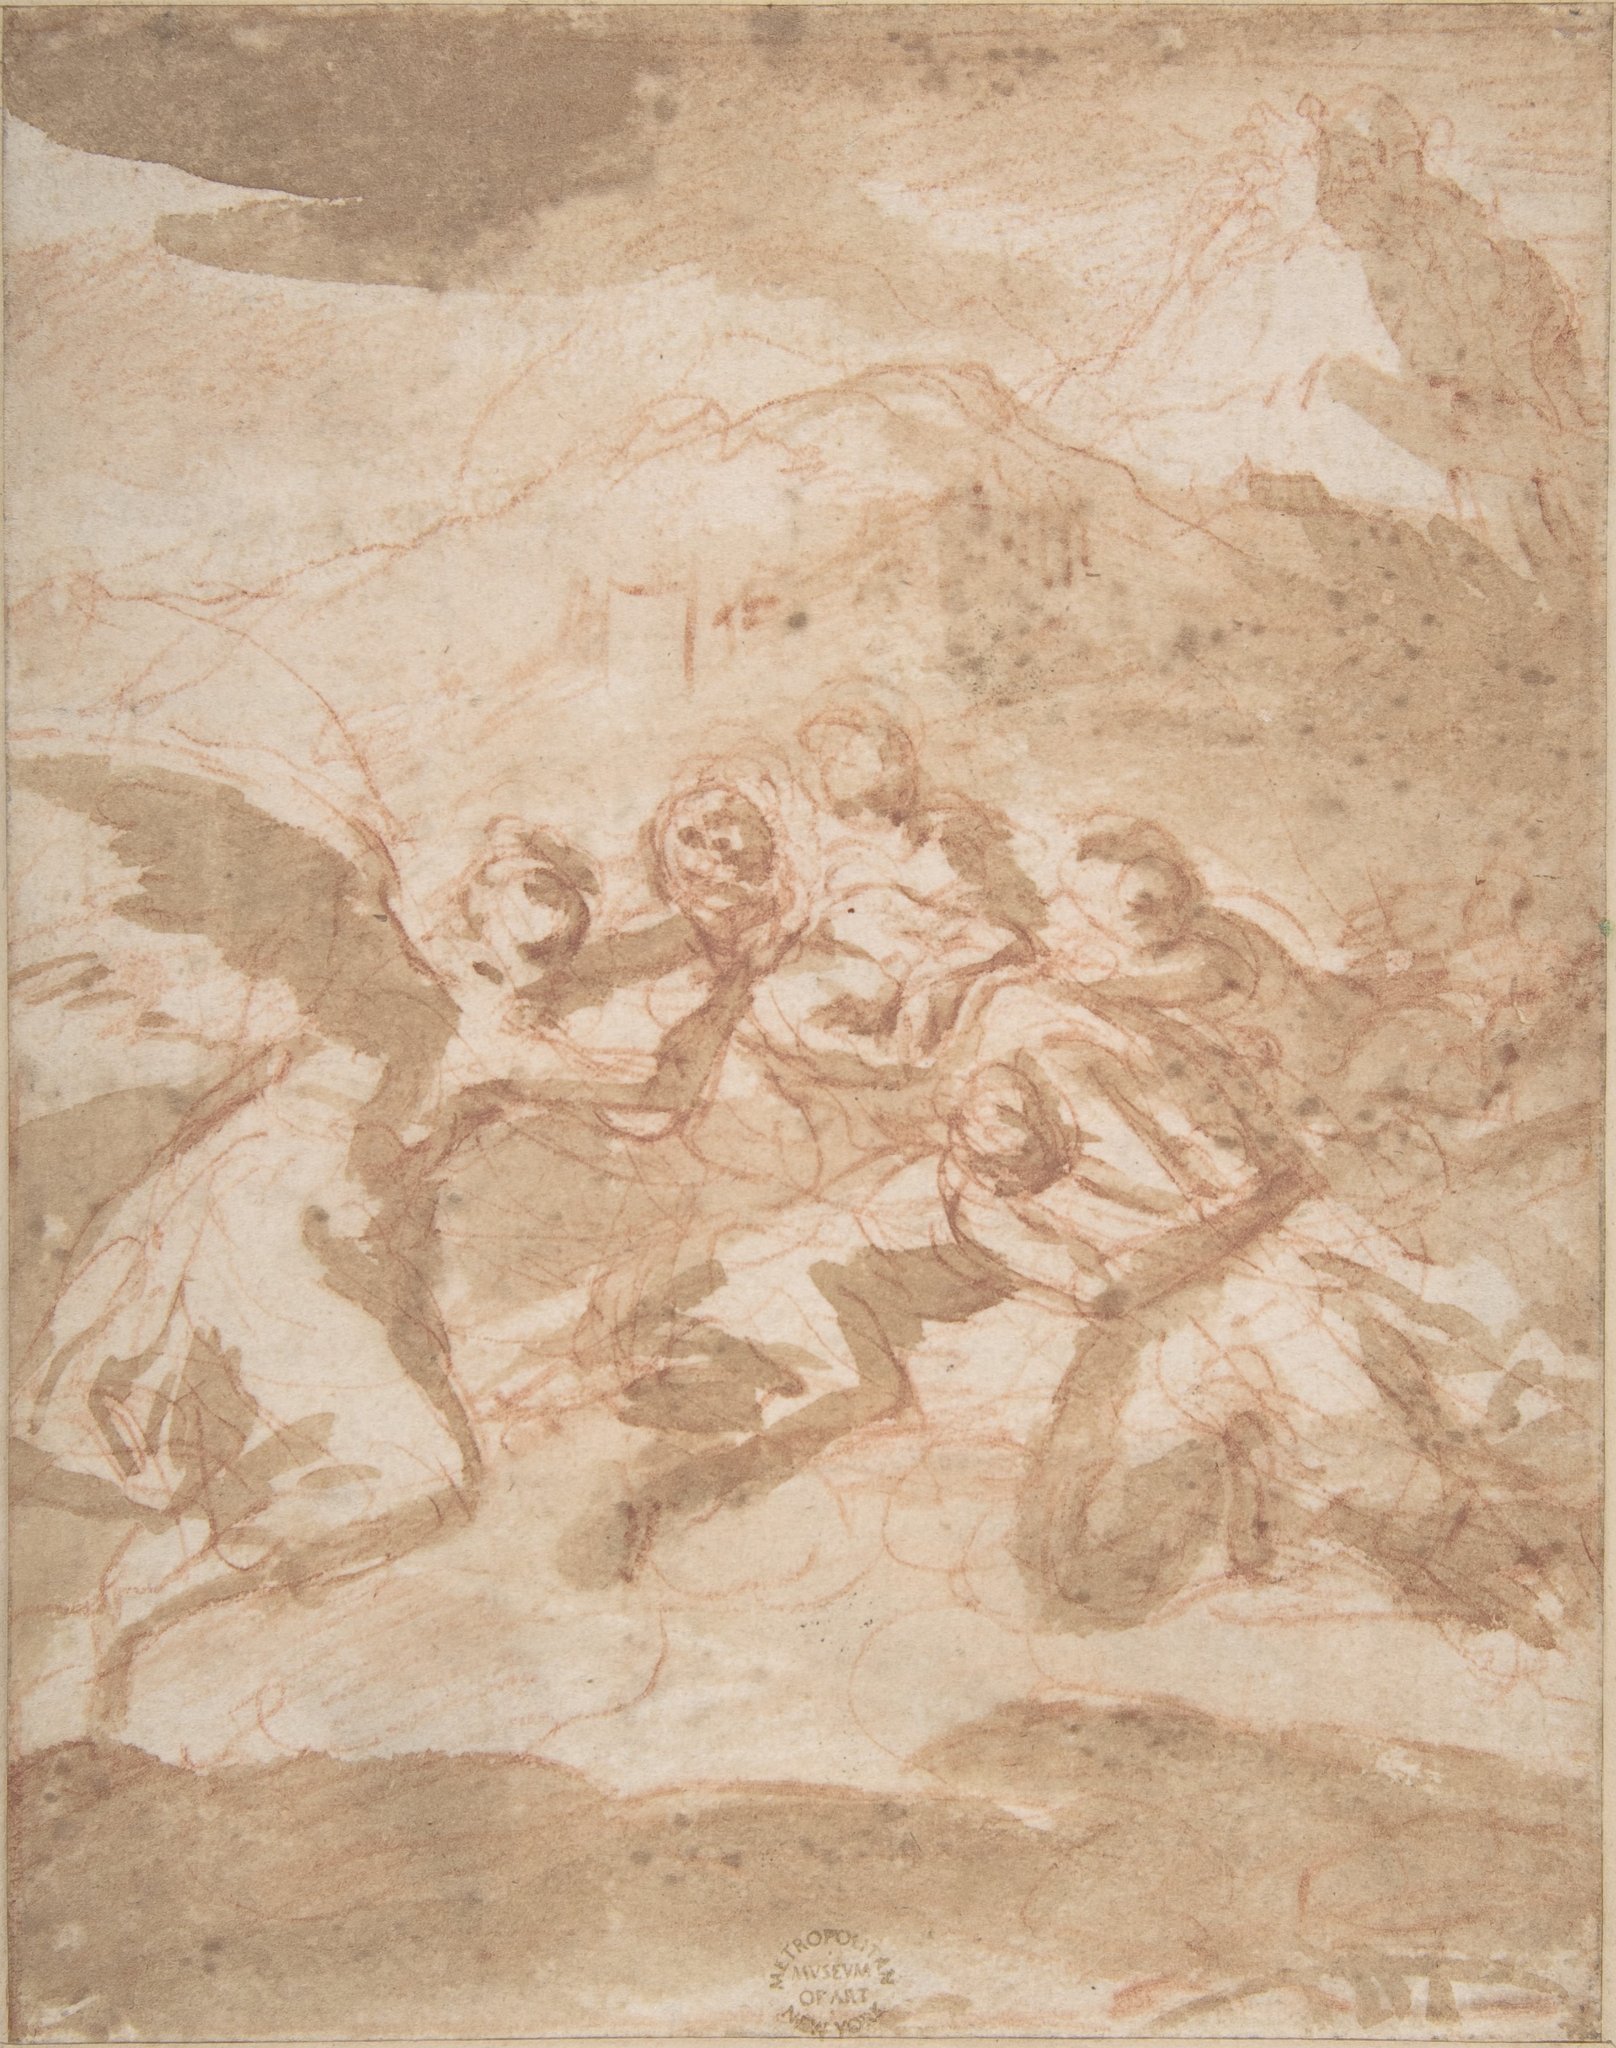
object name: drawing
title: Angels Carrying a Saint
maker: anonymous, italian, roman-bolognese, 17th century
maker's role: artist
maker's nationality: italian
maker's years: 1600-1700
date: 1601-1700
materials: chalk, paper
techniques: brush, wash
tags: angels,saints